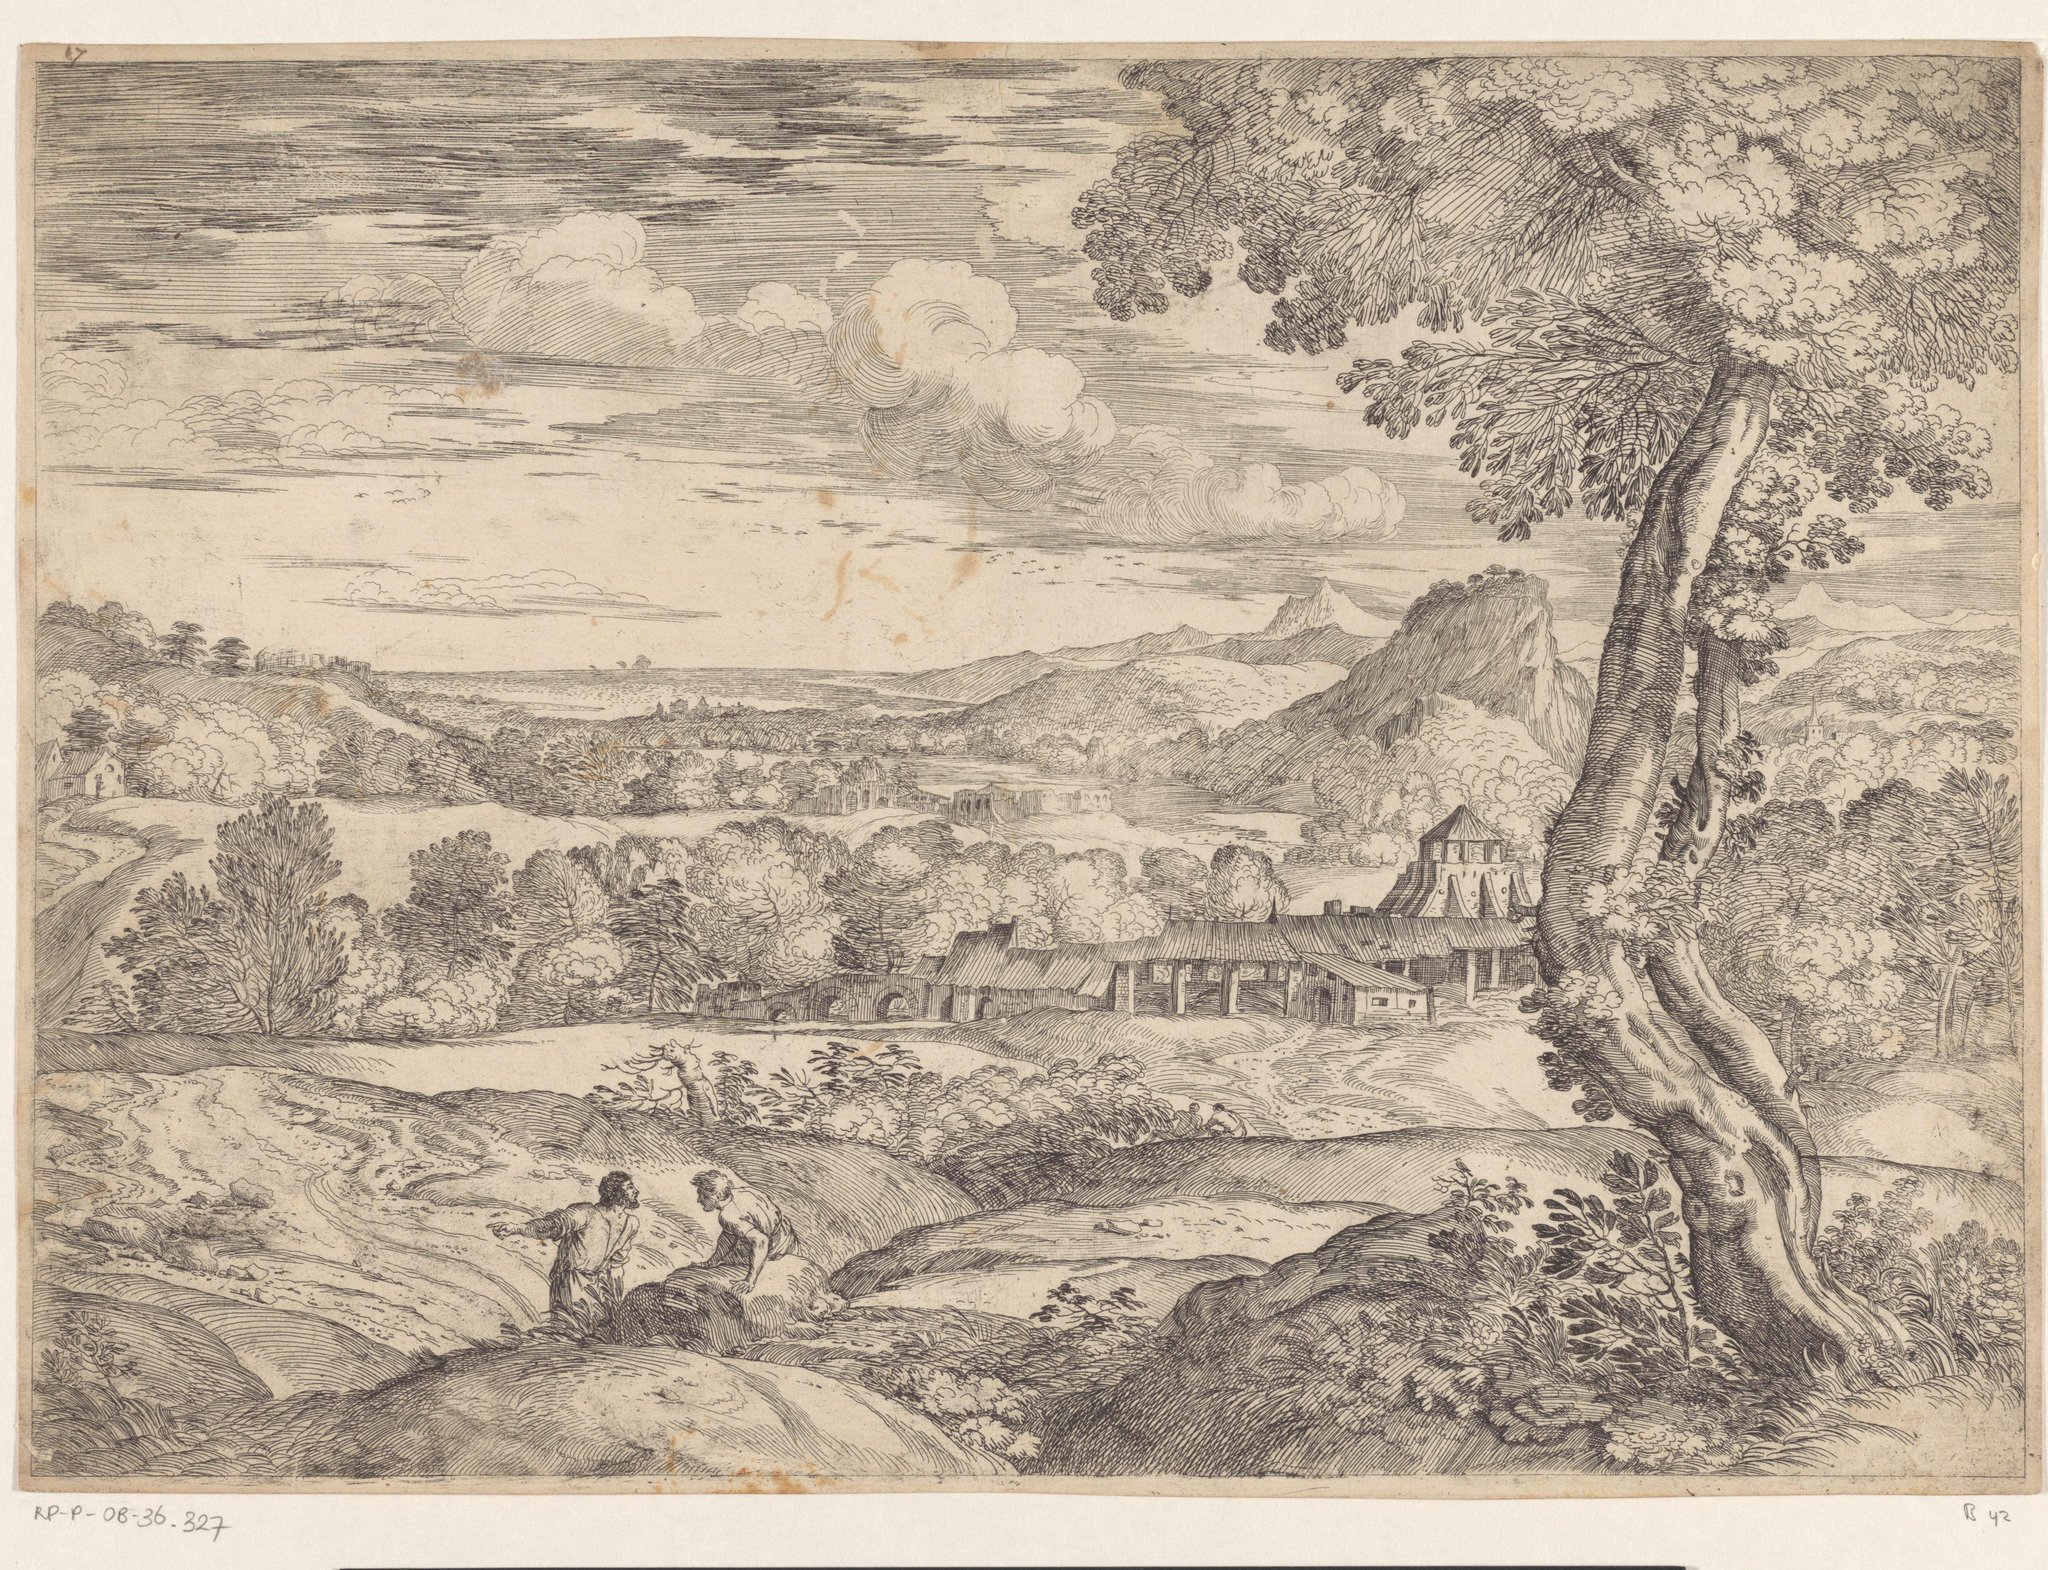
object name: print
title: Landschap met een steenfabriek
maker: giovanni francesco grimaldi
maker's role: draughtsman, print maker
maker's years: 1606-1680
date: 1616-1680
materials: paper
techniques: etching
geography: italy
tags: factory-building, landscapes, factory in landscape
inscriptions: collector's mark: Lugt 240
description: Een weids landschap met een steenfabriek. Op de voorgrond links twee mannen in gesprek.